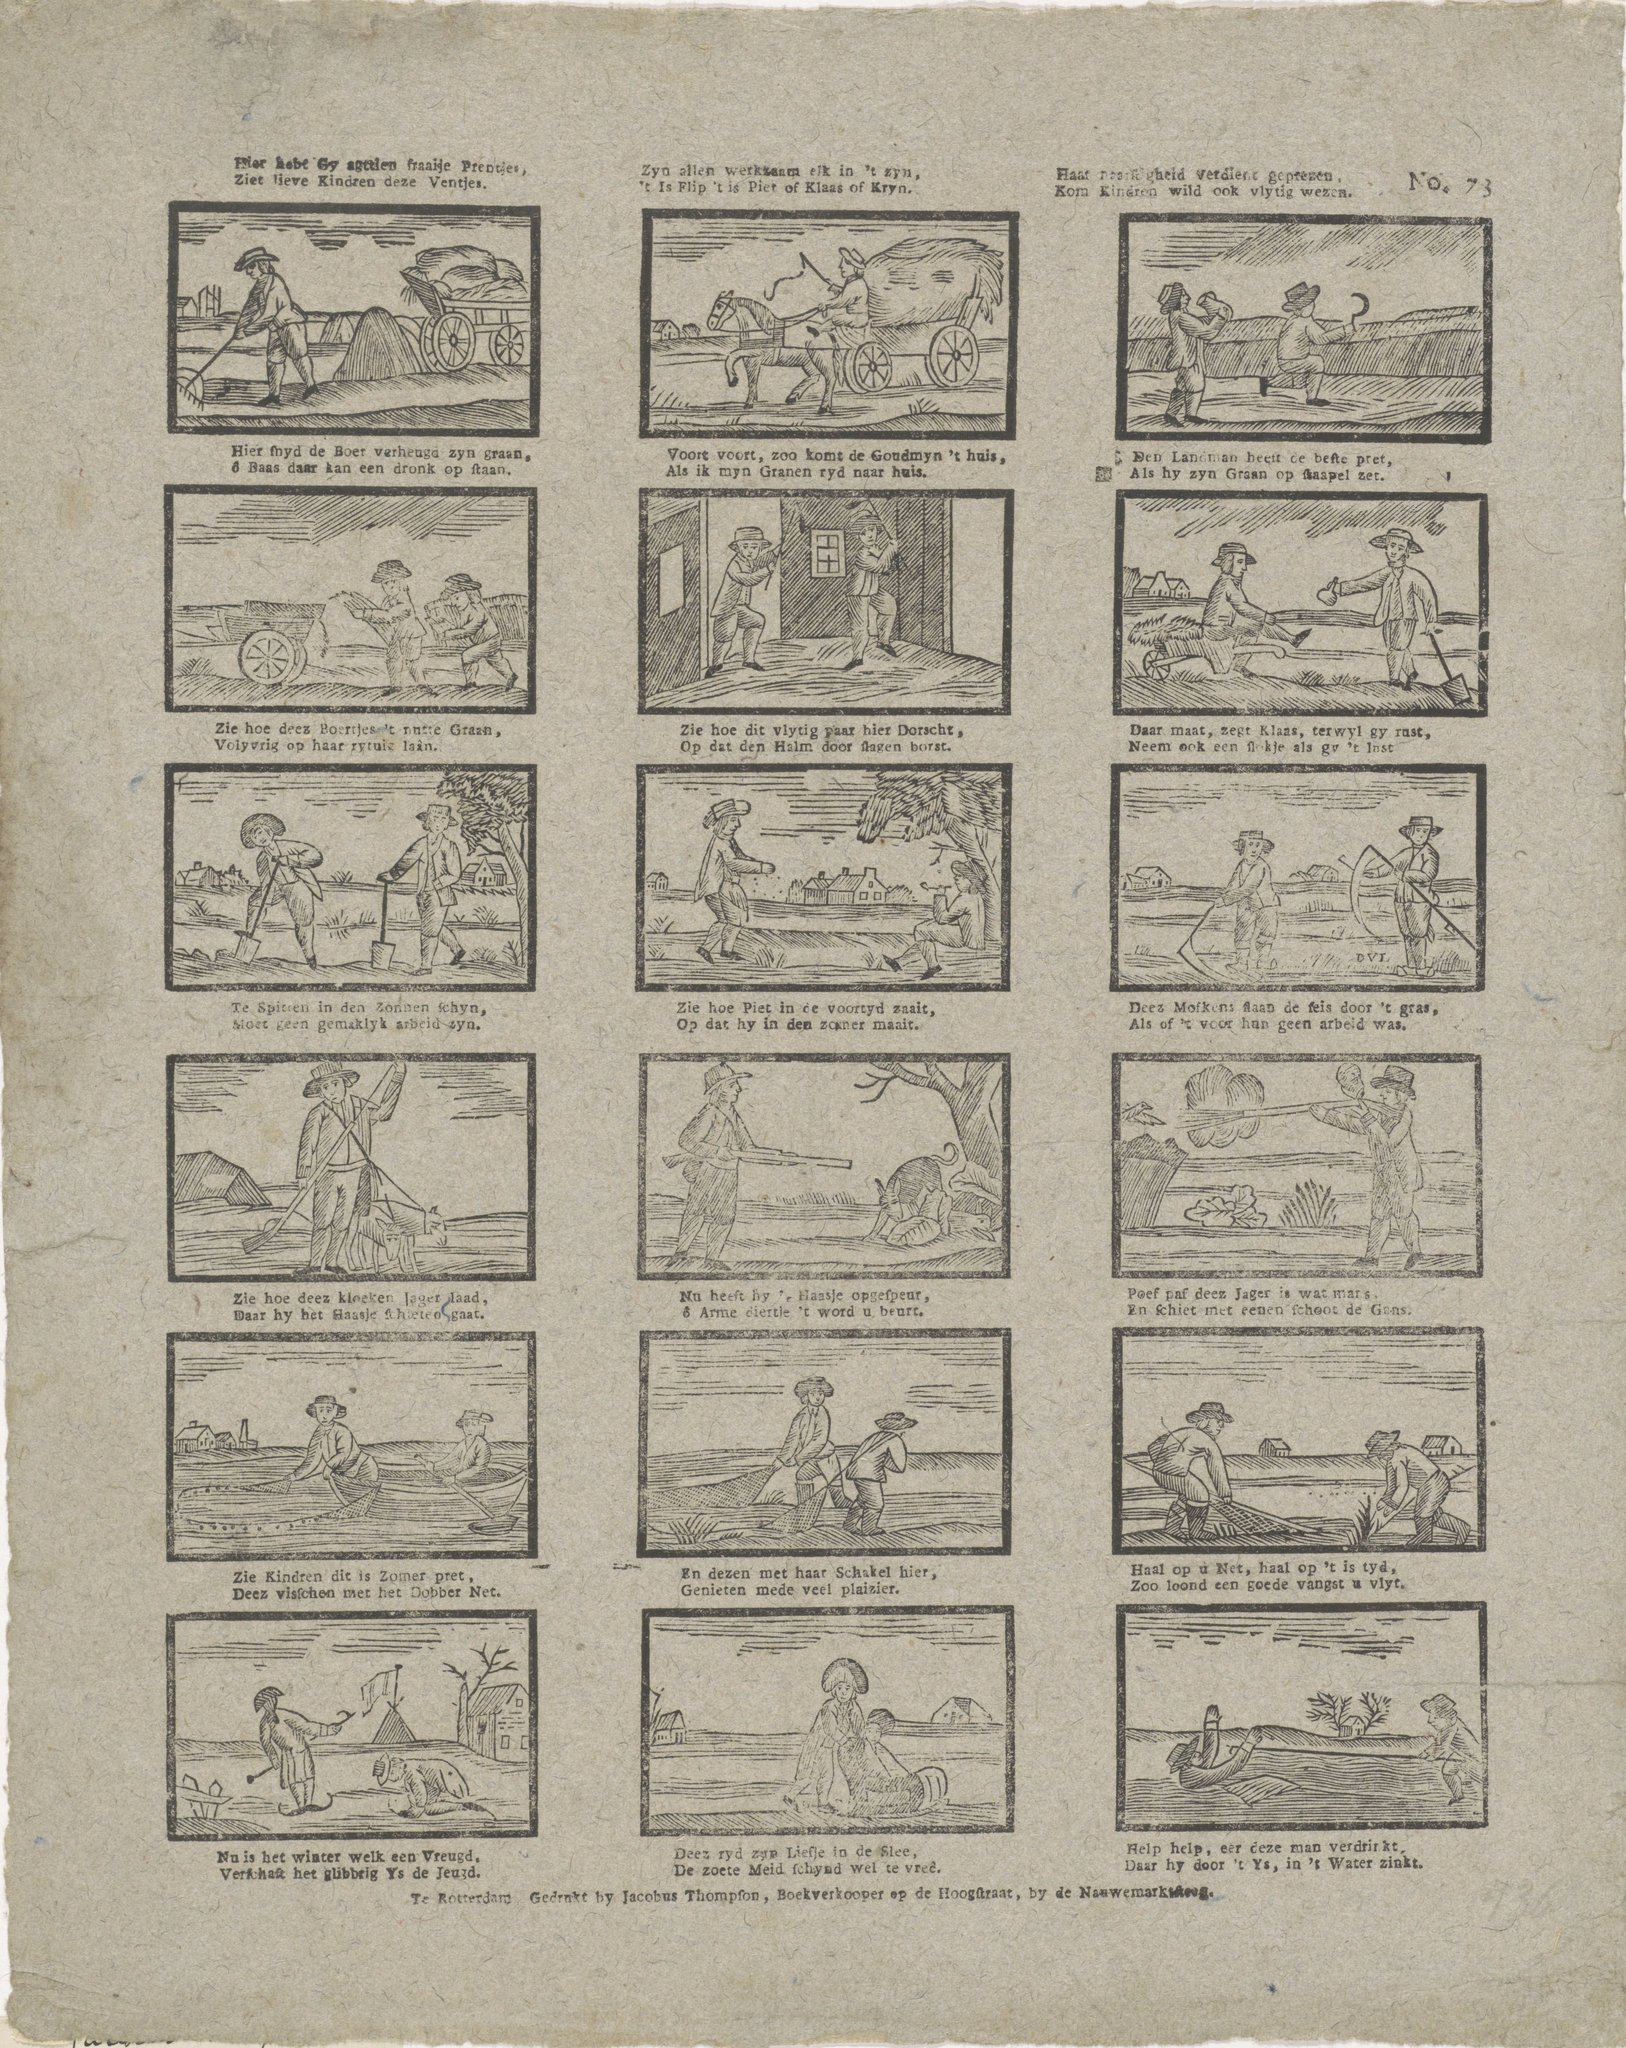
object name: print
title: Hier hebt gy agttien fraaije prentjes, / Ziet lieve kindren deze ventjes (...)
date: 1791-1812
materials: paper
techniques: letterpress printing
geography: rotterdam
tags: bird hunting, fishing (sports), hunt ~ mammals, agriculture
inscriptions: collector's mark: Lugt 2760, collector's mark: Lugt 2228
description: Blad met 18 voorstellingen van landelijke taferelen, waaronder boeren die het land bewerken, een jager op jacht en twee jongens die vissen met een net. Onder elke voorstelling een tweeregelig vers. Genummerd rechtsboven: No. 73.